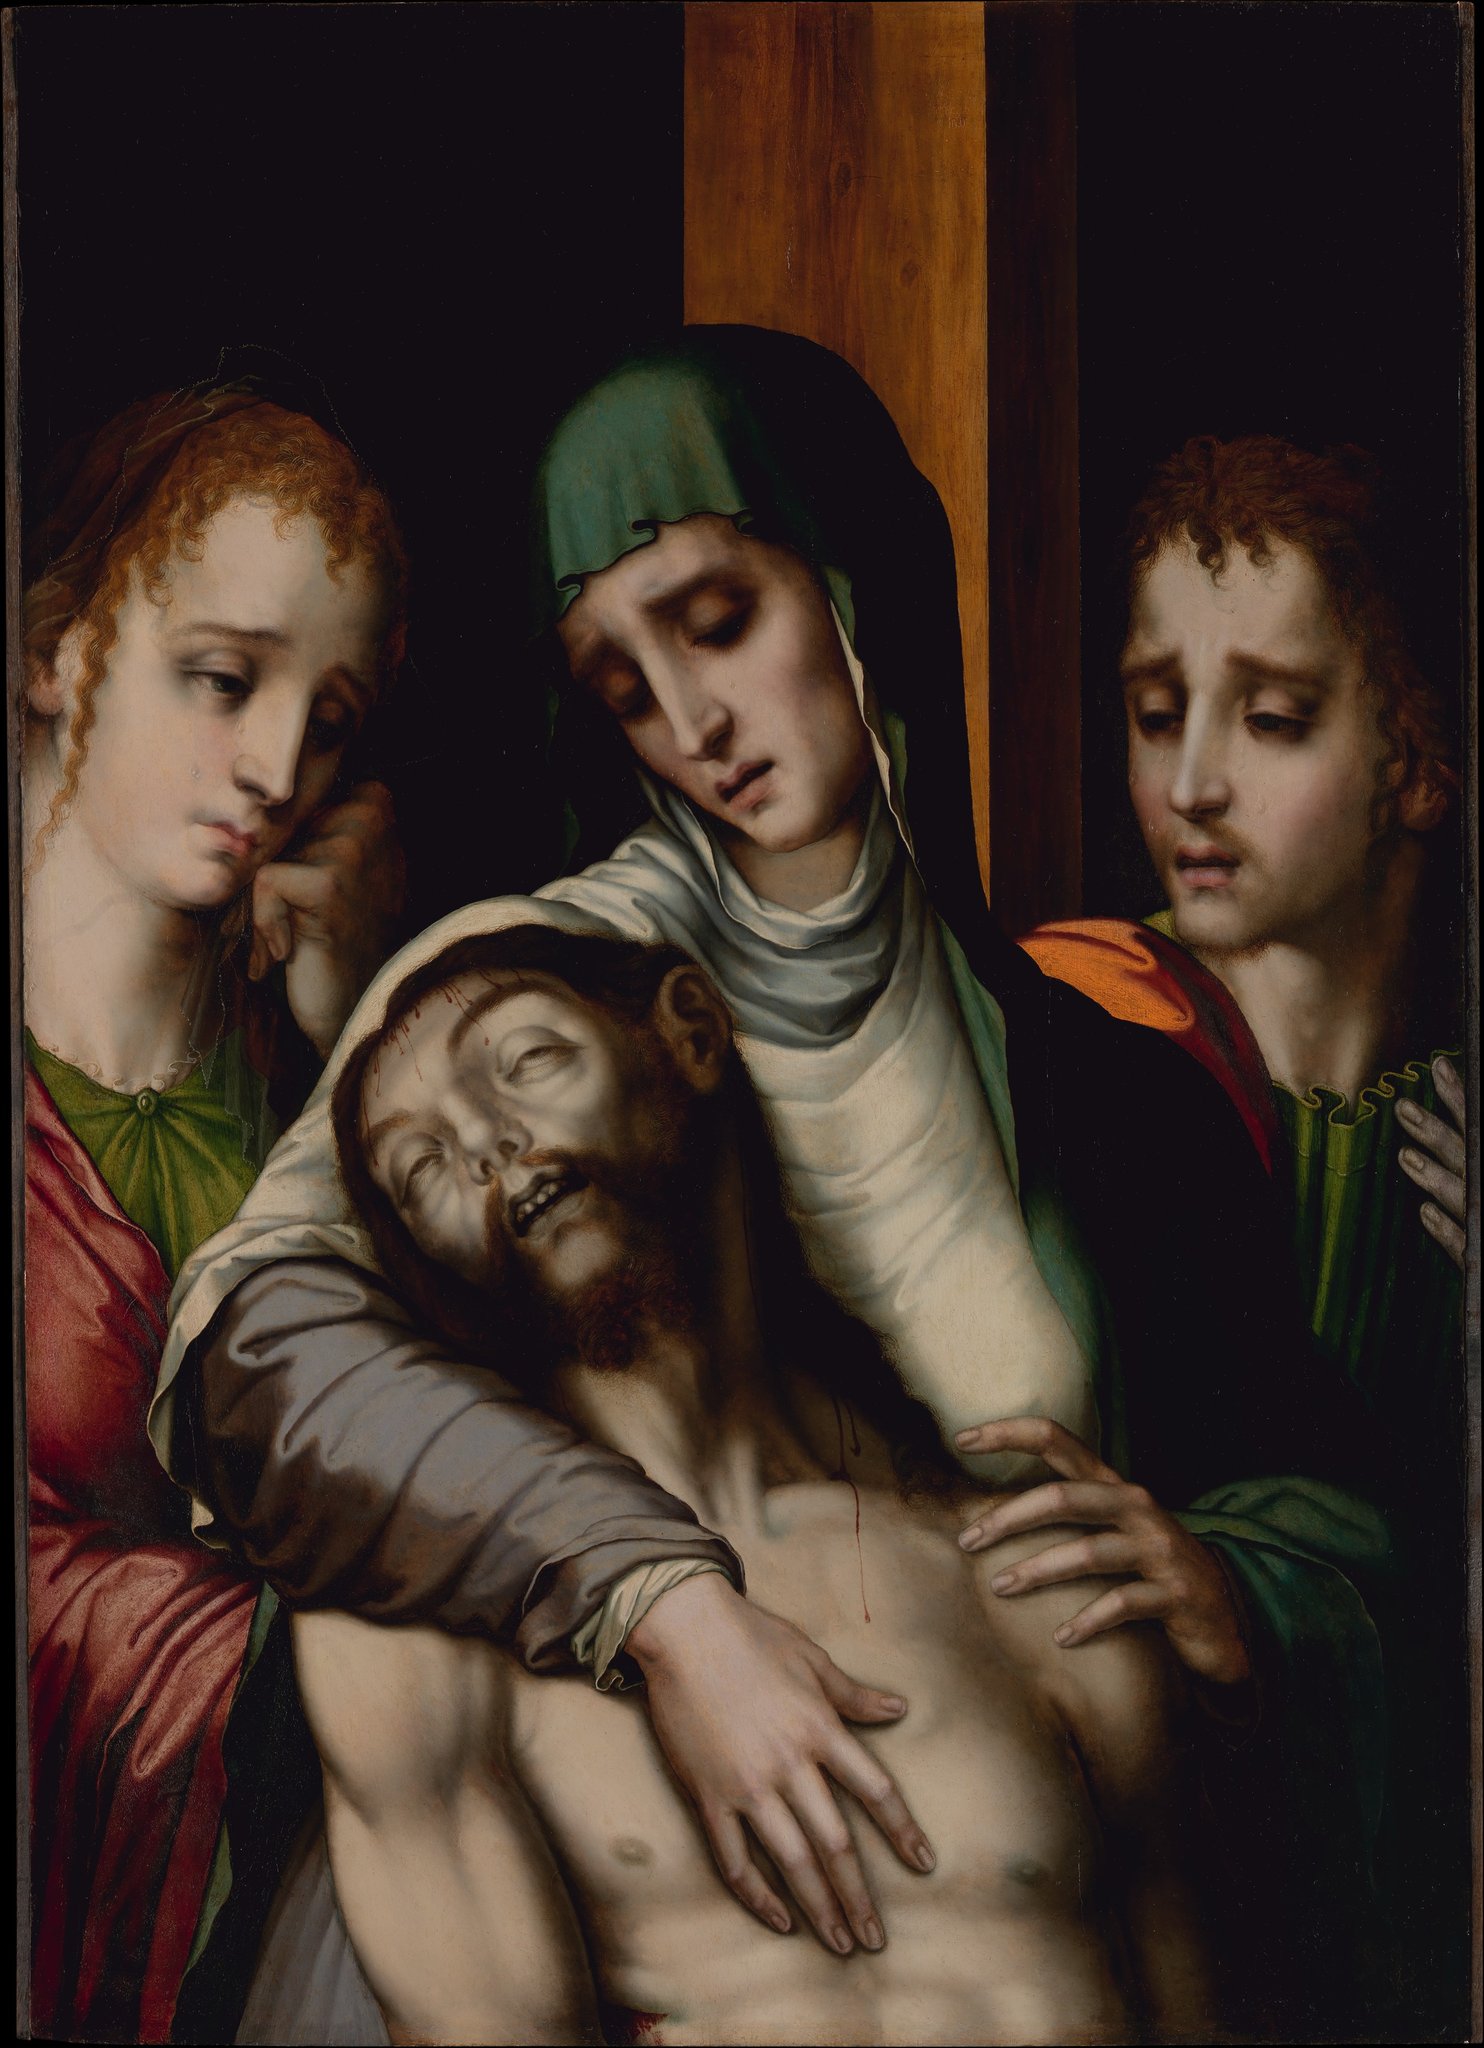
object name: painting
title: The Lamentation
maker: luis de morales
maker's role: artist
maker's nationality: spanish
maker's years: 1510-1586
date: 1560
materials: oil, wood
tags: men,women,christ,mary magdalene,saint john the evangelist,virgin mary,lamentation